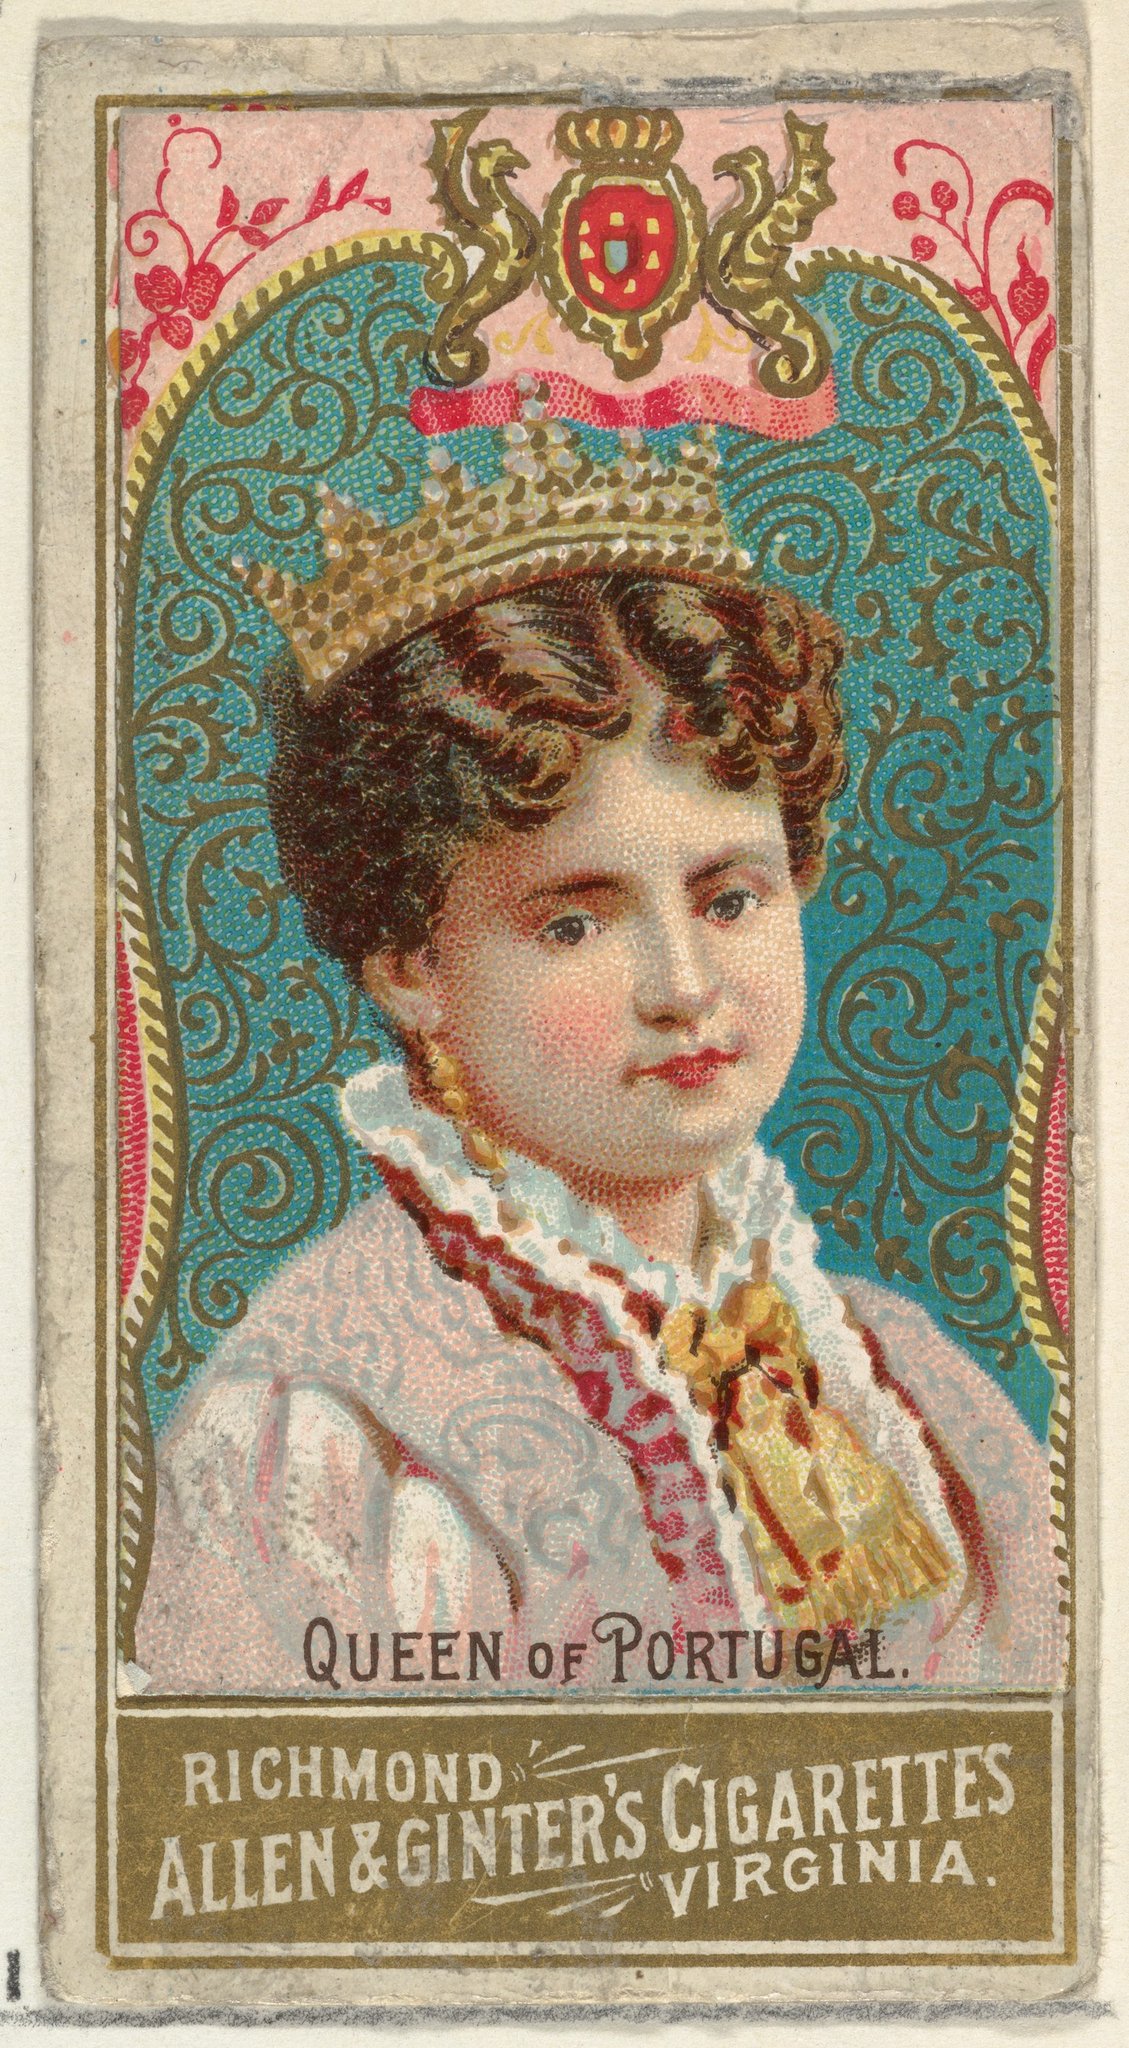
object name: print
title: Queen of Portugal, from World's Sovereigns series (N34) for Allen & Ginter Cigarettes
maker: allen & ginter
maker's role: publisher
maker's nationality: american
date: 1889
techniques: color lithograph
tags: queens,portraits,coat of arms